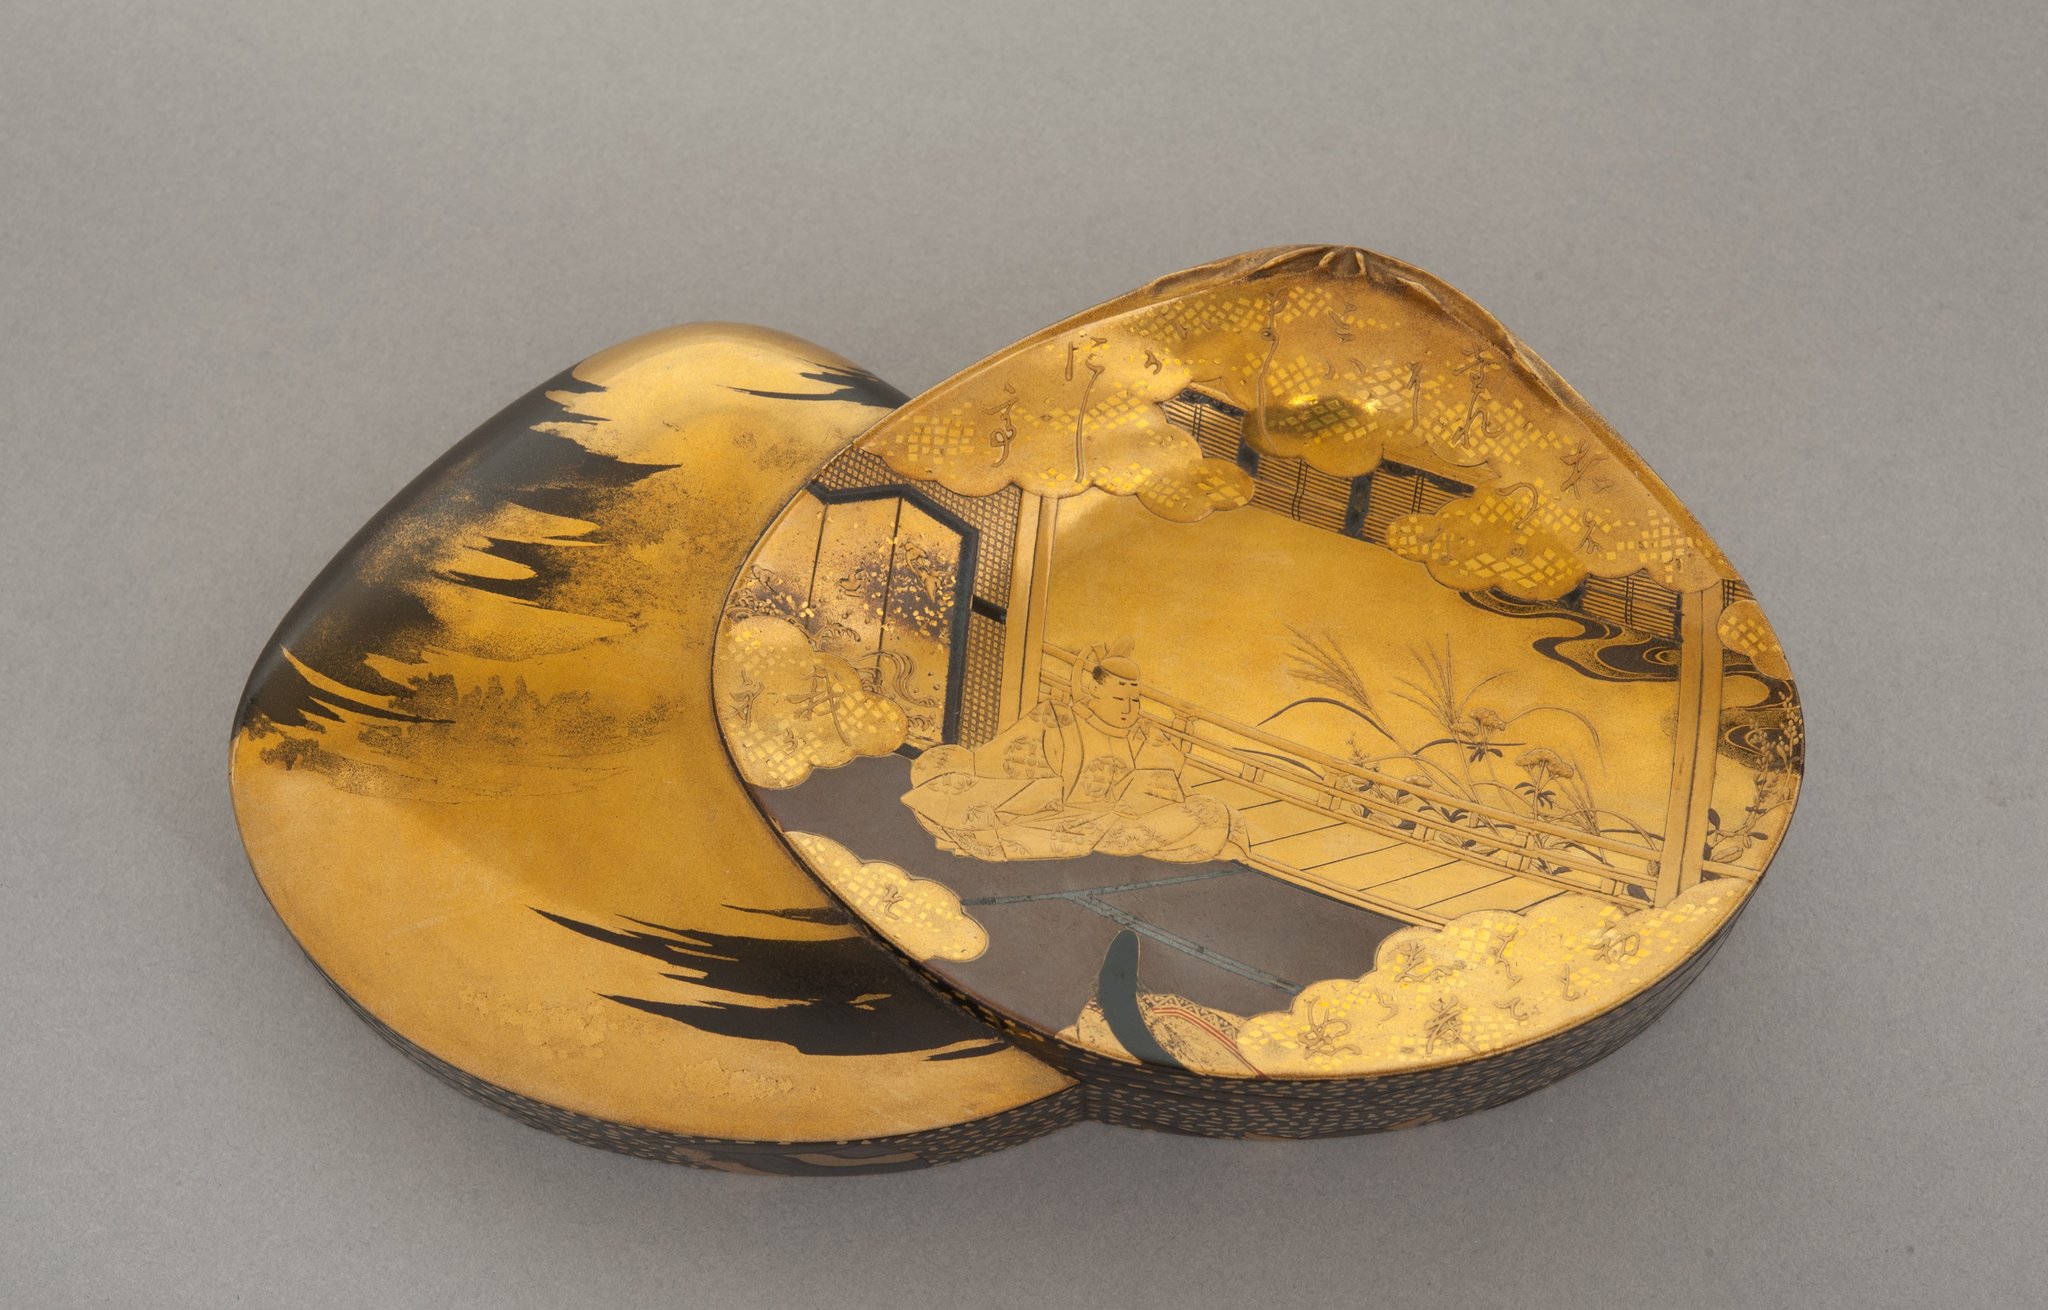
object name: incense box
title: Incense Box (Kōbako) with Scene from The Tale of Genji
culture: japanese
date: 1851-1900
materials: foil, gold, silver, wood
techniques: hiramakie, lacquer, maki-e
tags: men